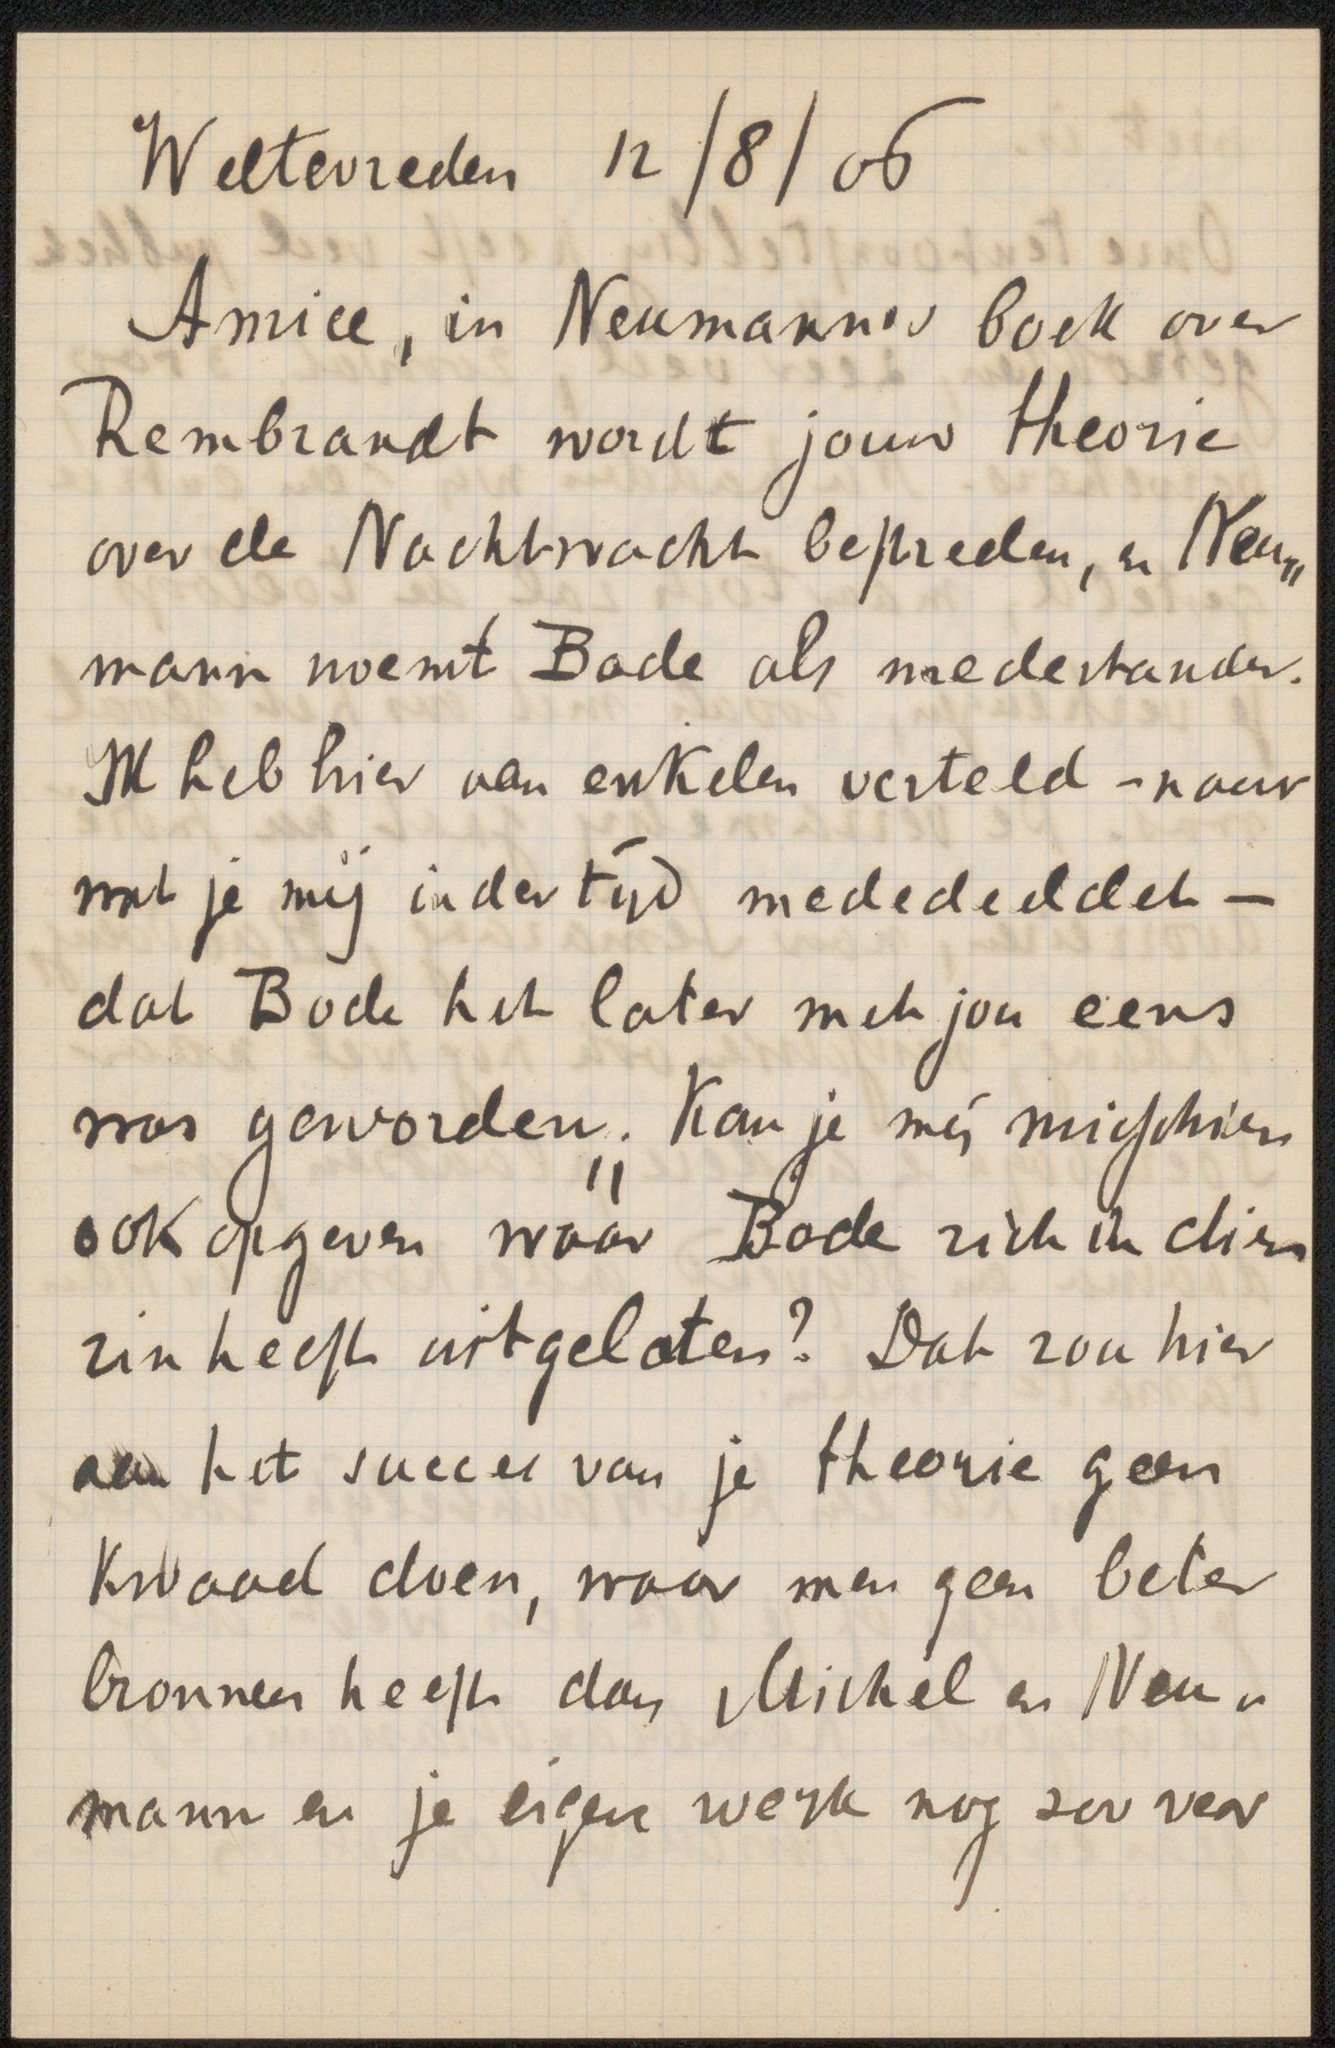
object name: letter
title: Brief aan Jan Veth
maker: chap van deventer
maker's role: kunstcriticus, scheikundige, schrijver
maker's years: 1860-1931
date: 1906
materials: ink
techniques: pen, writing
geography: weltevreden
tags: designer, jan veth, leiden, draughtsman, rembrandt van rijn, berlin, wilhelm von bode, paris, painter, françois émile michel, painting (including book-illumination, miniature-painting), exhibition ~ art, surabaya, batavia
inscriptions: collector's mark: ‘RPK’